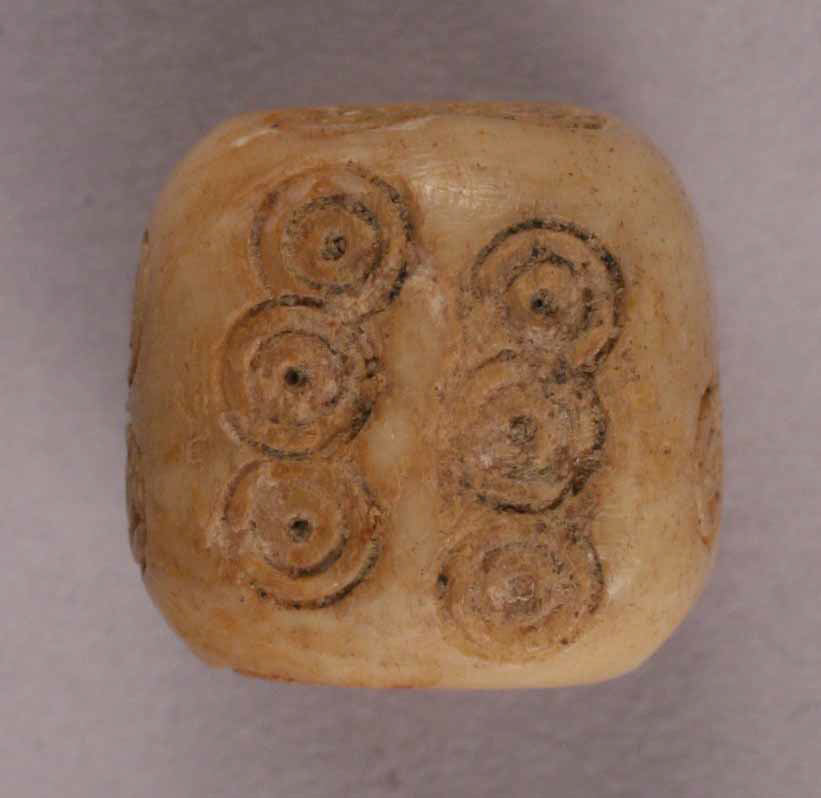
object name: dice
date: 801-1000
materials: bone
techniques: incising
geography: iran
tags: dice